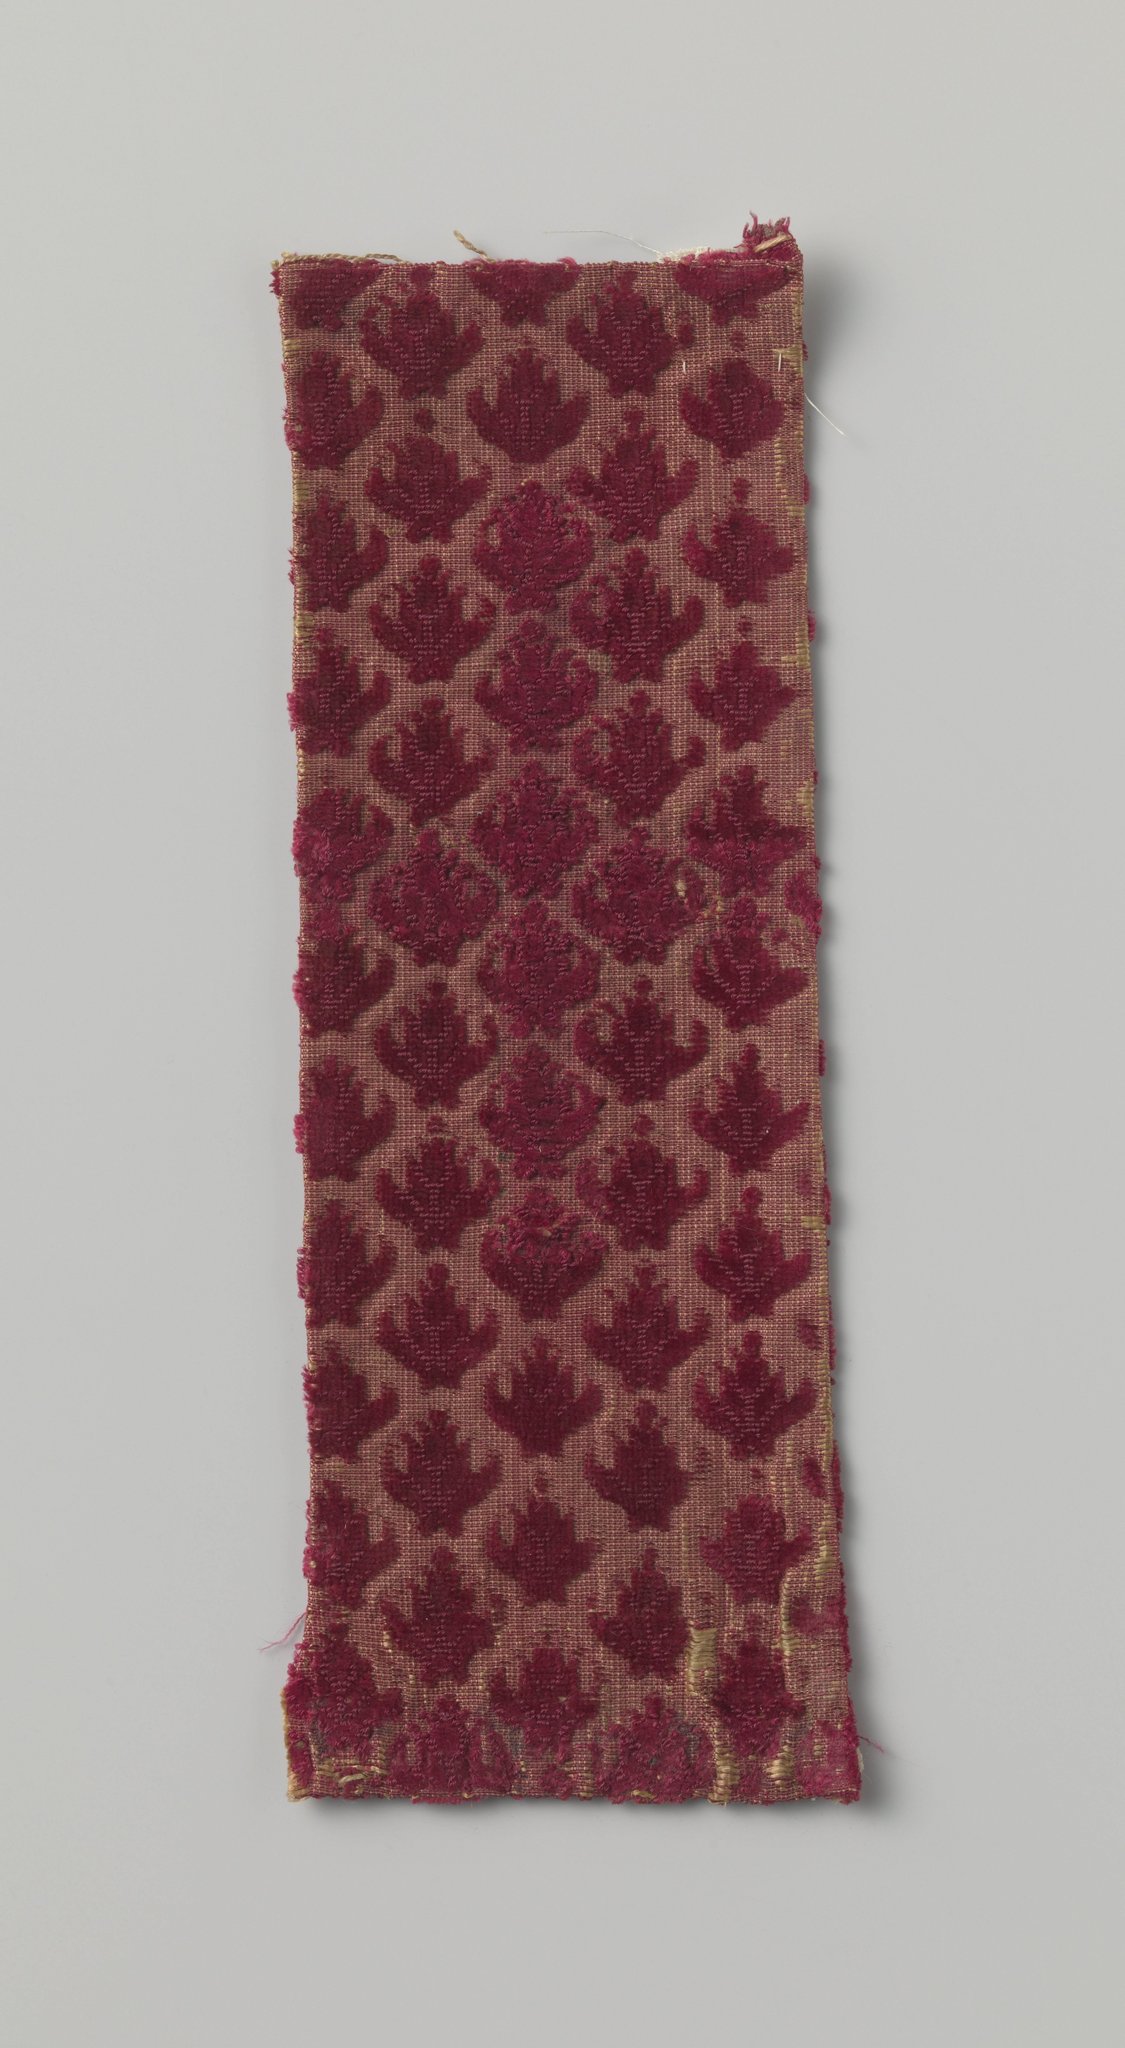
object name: zijdefluweel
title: Fragment zijdefluweel met geschoren patroon van verspringende rijen palmetten in paarsrood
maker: Anonymous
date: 1550-1599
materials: silk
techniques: velvet, weave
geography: italy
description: Fragment zijdefluweel met geschoren patroon van verspringende rijen palmetten in paarsrood. Italië, 16de eeuw.